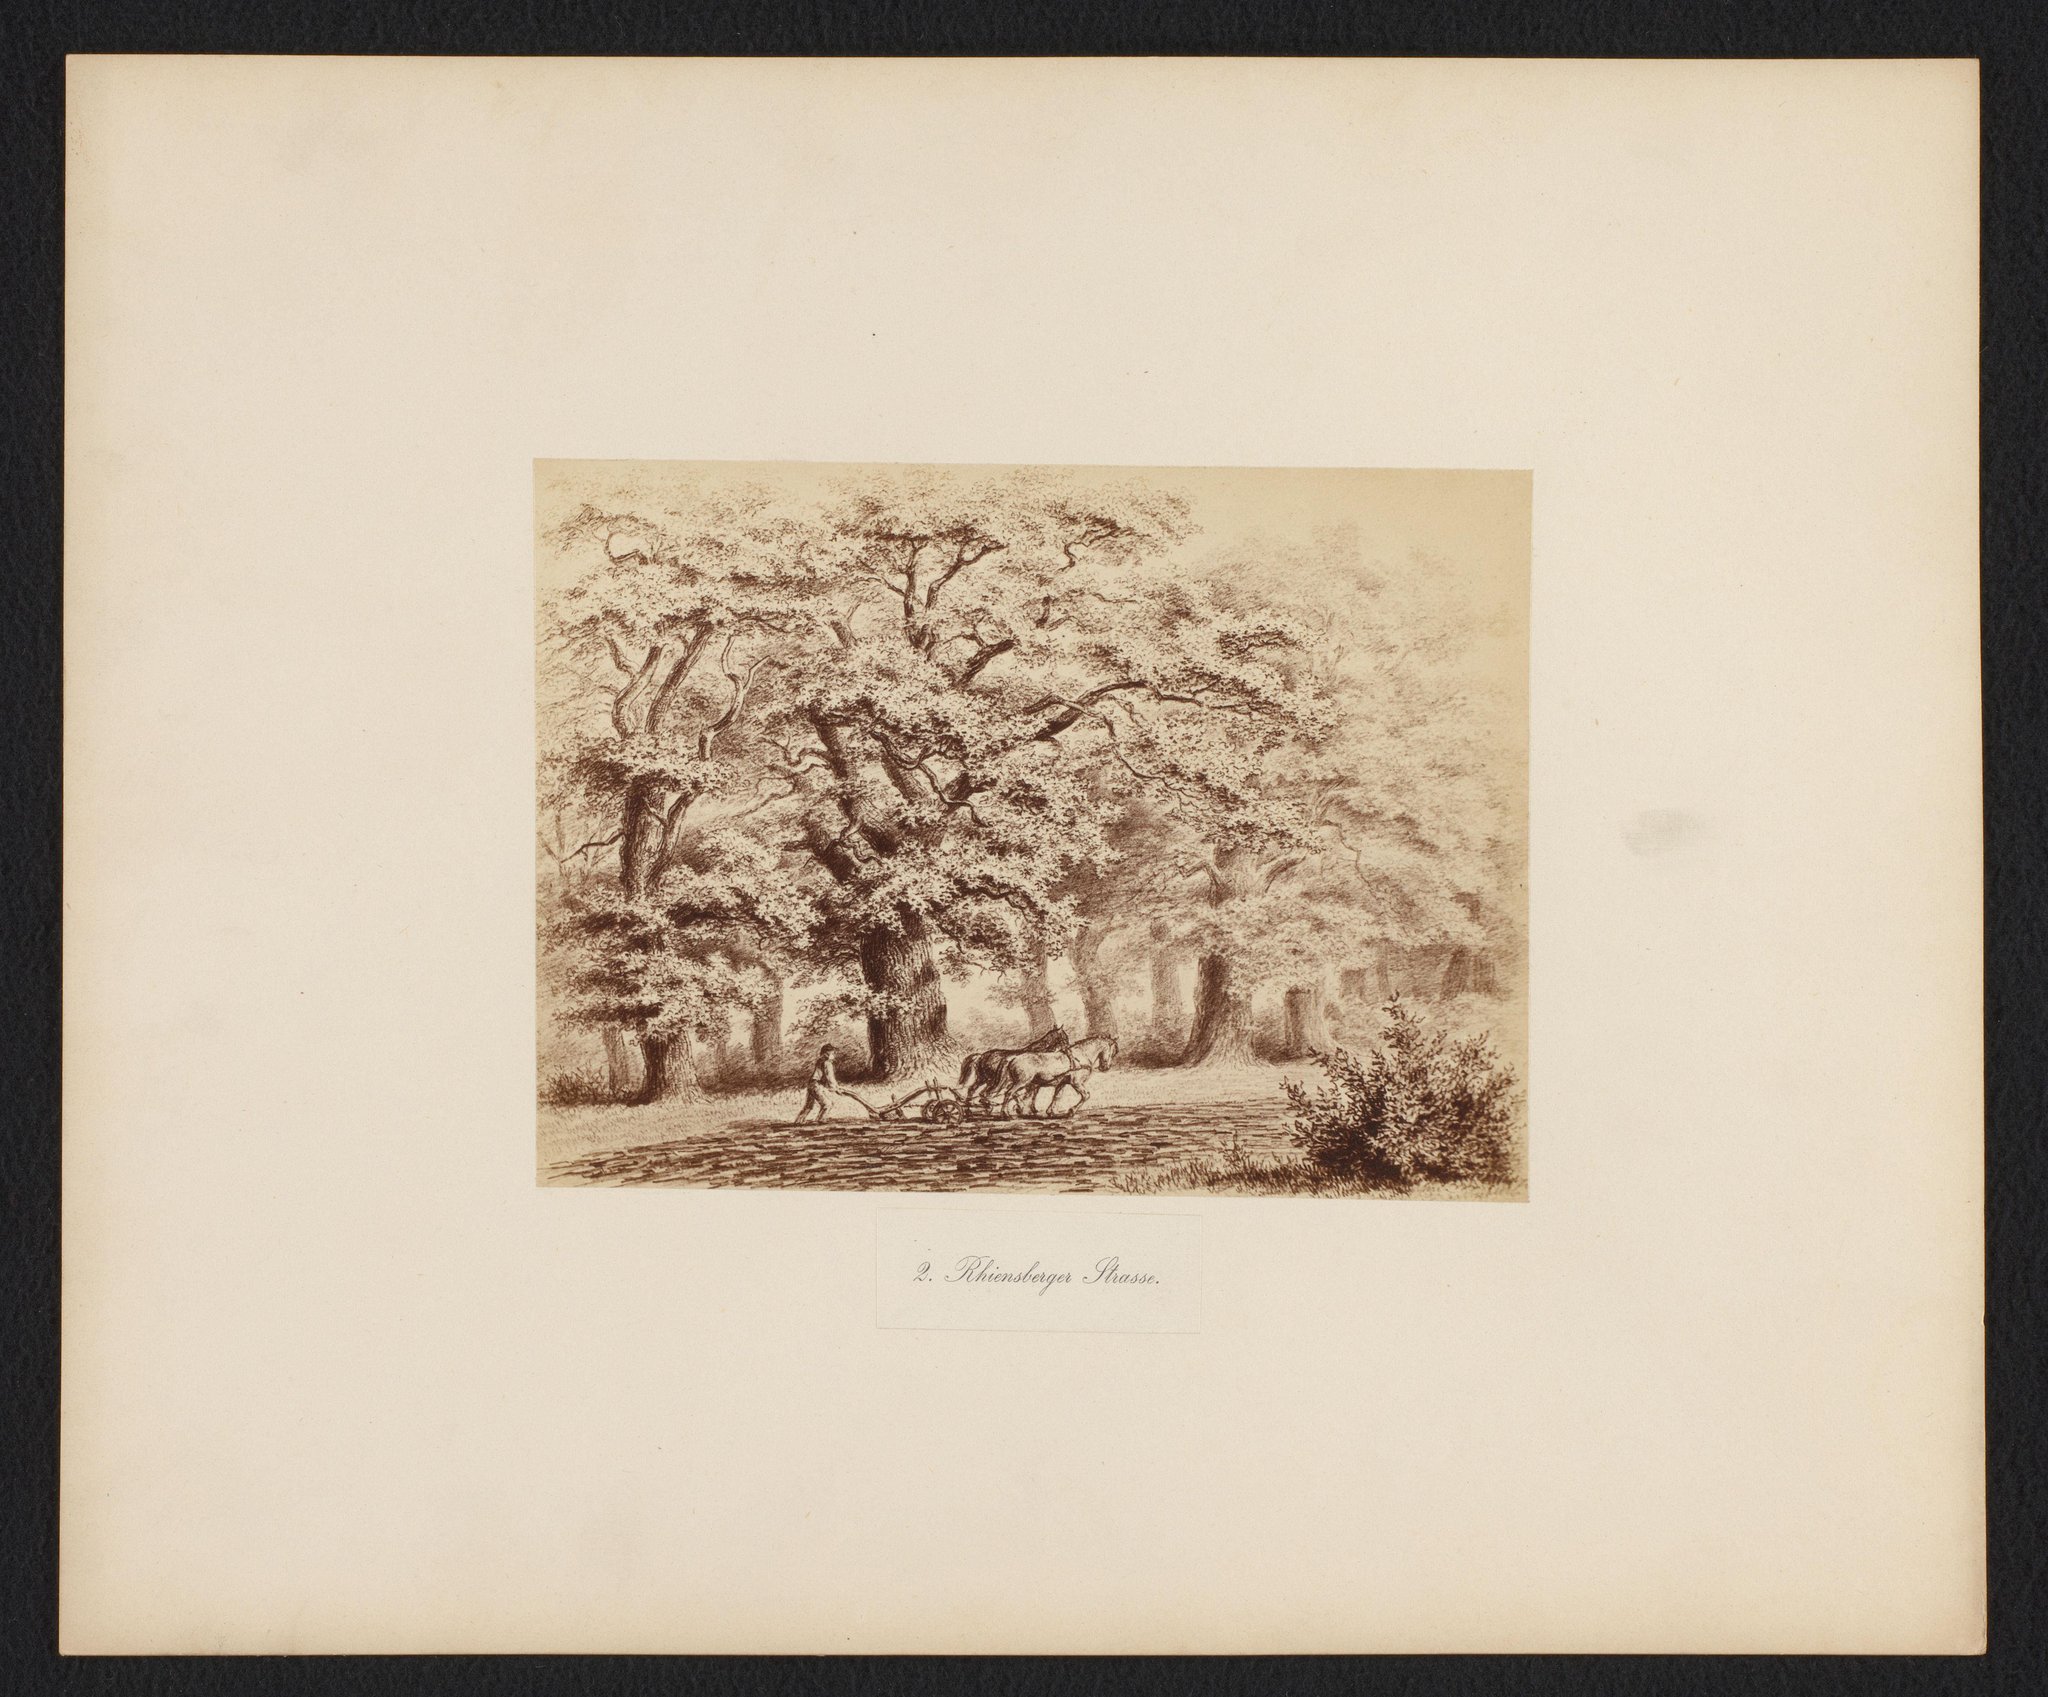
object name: photograph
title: 2. Rhiensberger Strasse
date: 1870-1875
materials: cardboard, paper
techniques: albumen print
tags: ploughing